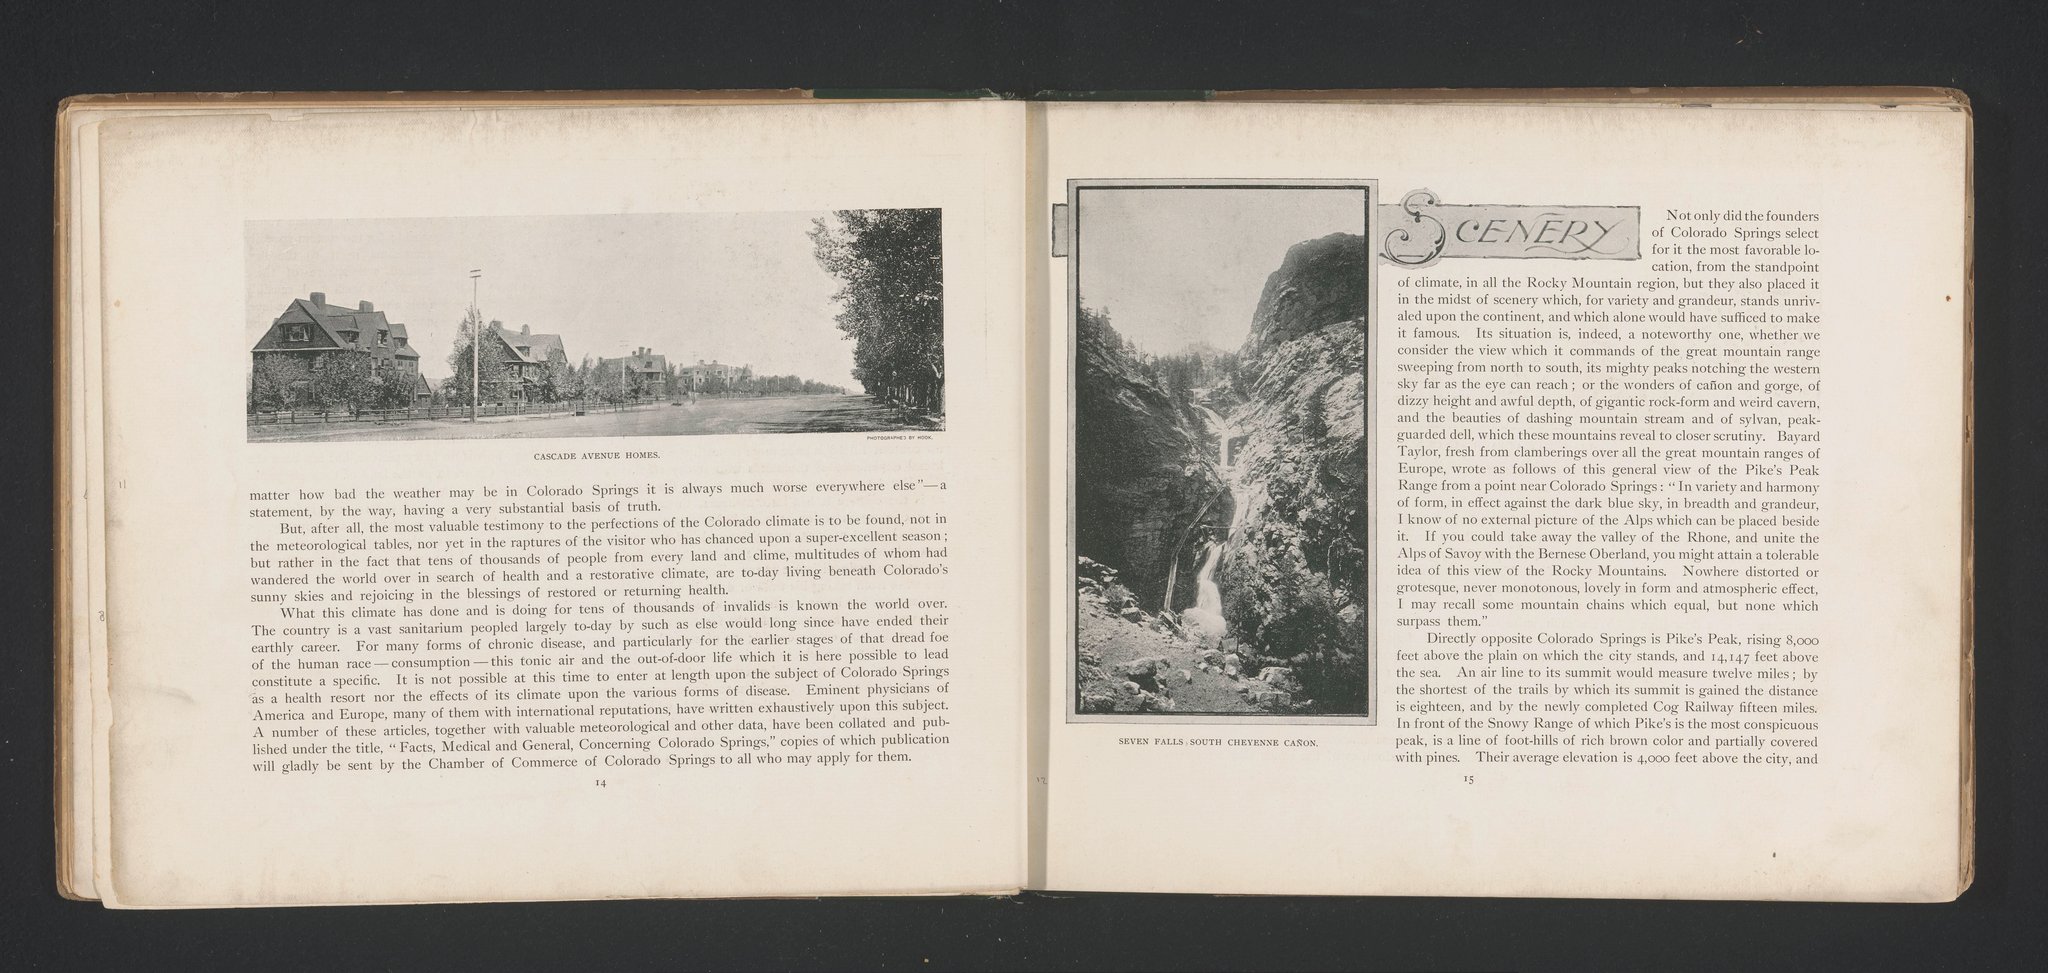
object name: photomechanical print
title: Waterval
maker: Anonymous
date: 1888-1893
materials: paper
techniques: autotype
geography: new york city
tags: waterfall